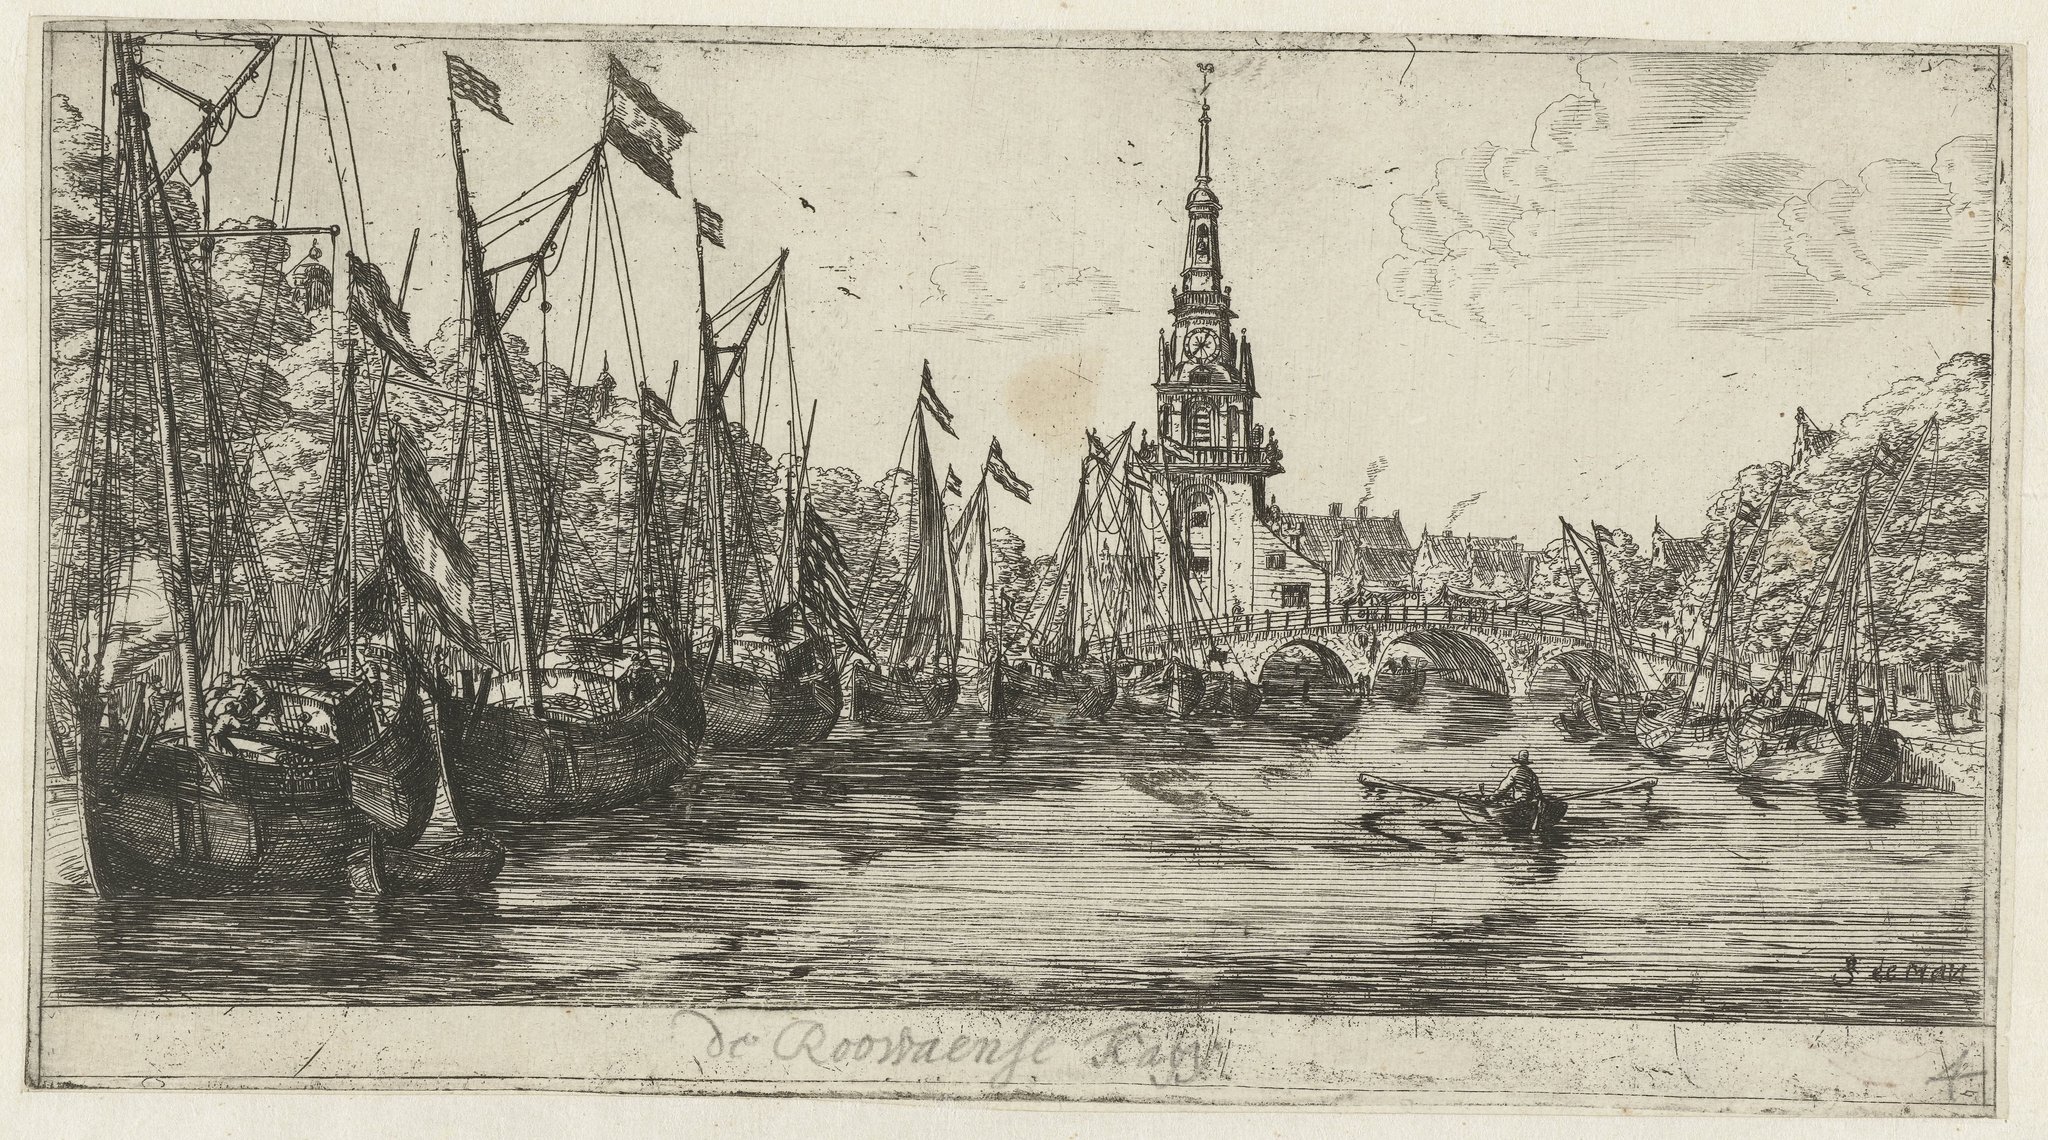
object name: print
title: Verscheide gesichten binnen Amsterdam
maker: reinier nooms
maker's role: draughtsman, painter, print maker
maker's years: 1623-1664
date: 1657-1662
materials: paper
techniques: etching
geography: netherlands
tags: city-view in general; 'veduta'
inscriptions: inscription: ‘4’, collector's mark: Lugt 240, inscription: ‘de Roowaense Kaey’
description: Singel, gezien in zuidelijke richting naar de Jan Rodenpoortstoren en de Torensluis. Links de Rouaanse Kade. Een rij schepen in het water langs de kade.